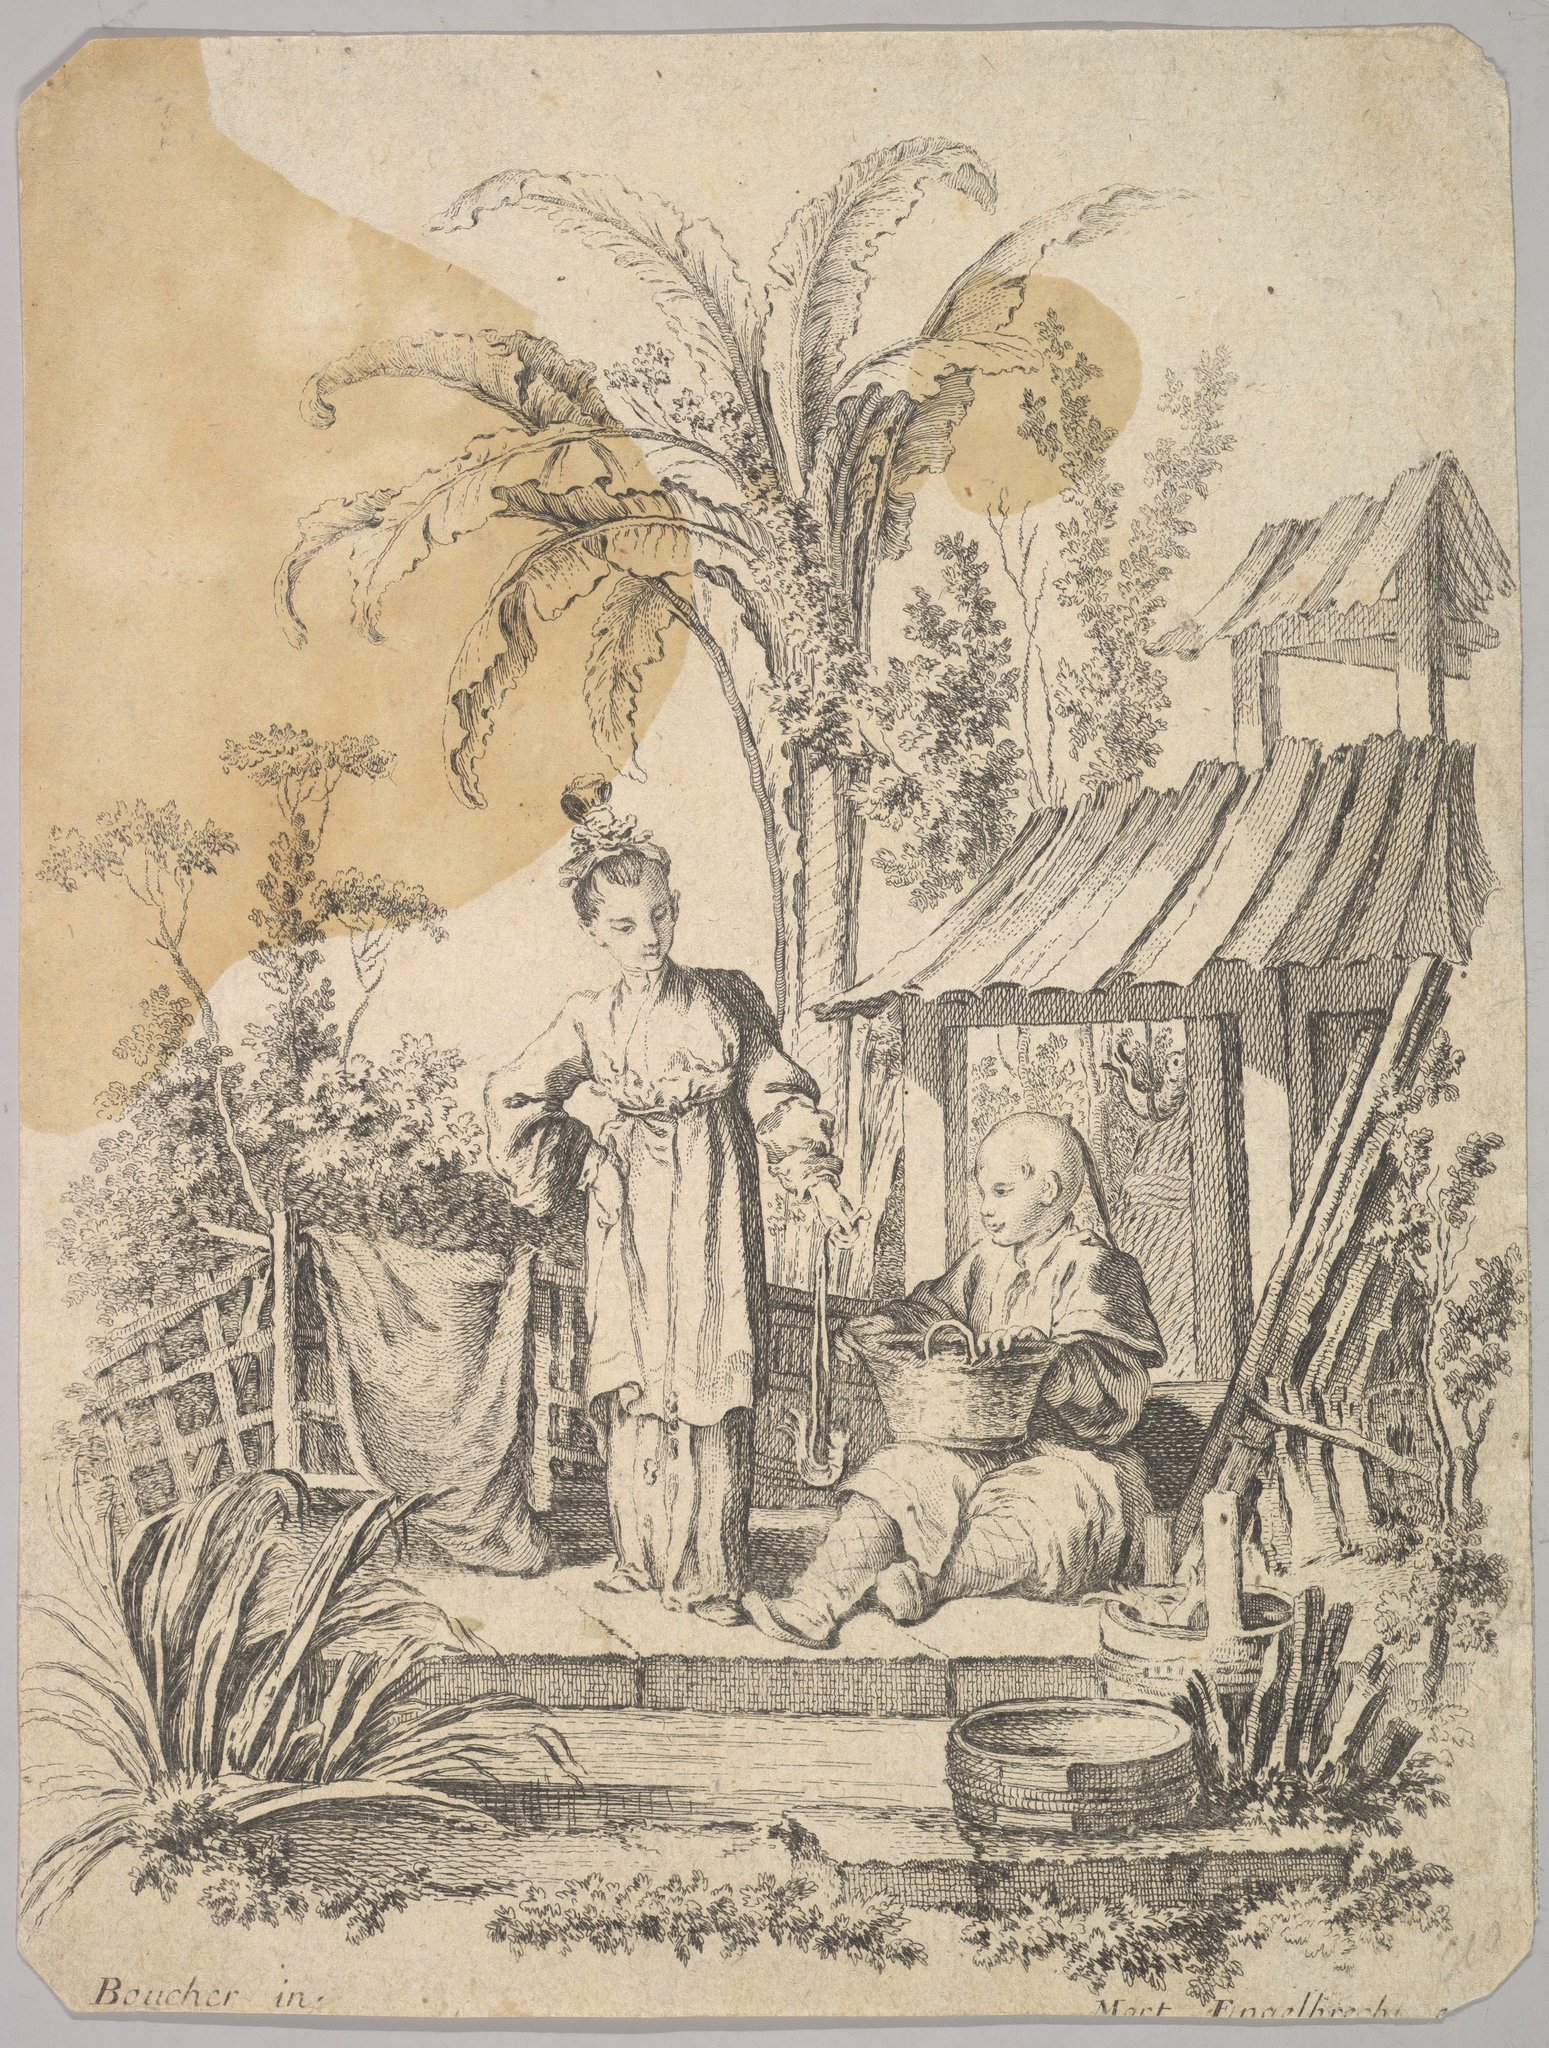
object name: print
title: Man Sitting and Woman Carrying a Fish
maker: martin engelbrecht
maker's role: artist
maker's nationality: german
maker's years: 1684-1756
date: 1701-1750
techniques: etching, stippling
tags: chinoiserie,men,women,fish,trees